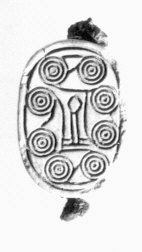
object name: stamp seal ring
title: Scarab seal ring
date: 1700-1560 BCE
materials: copper alloy, stone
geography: levant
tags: scarabs